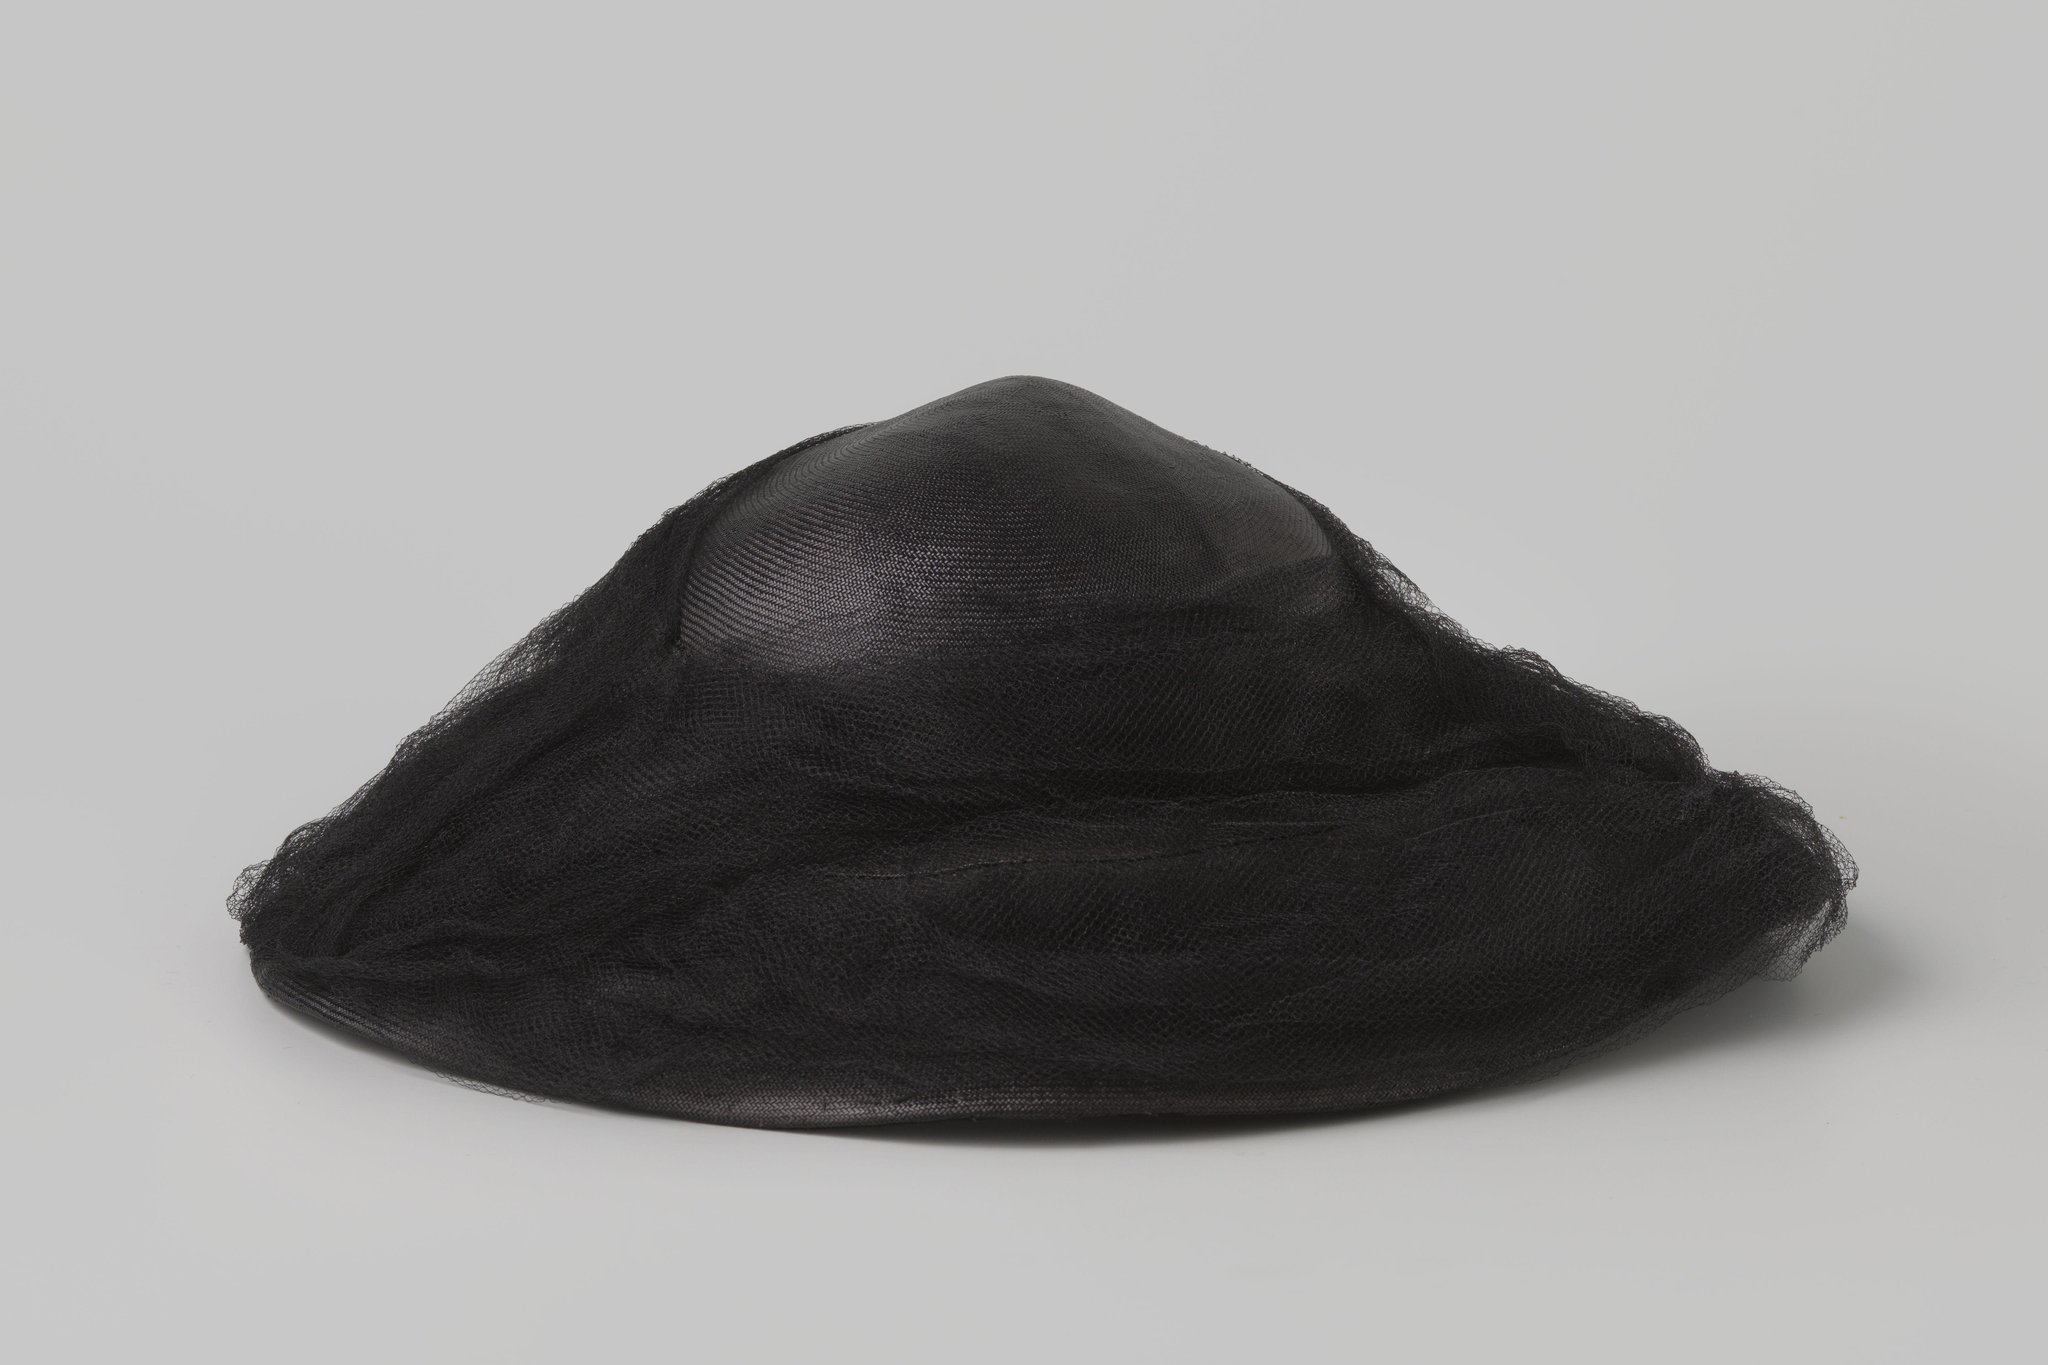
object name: hat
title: Dameshoed van zwart raffia met zwarte tule en lint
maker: Anonymous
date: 1949-1950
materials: silk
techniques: rib binding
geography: netherlands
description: Dameshoed, rouwhoed, van panamastro, zwart gelakt. De rand is tegenbelegd met zwarte ripszijde. Rondom met gedrapeerde zwarte tulle. Model: plat, baretvormig, met verzonken binnenkap, verstevigd met metaaldraad.